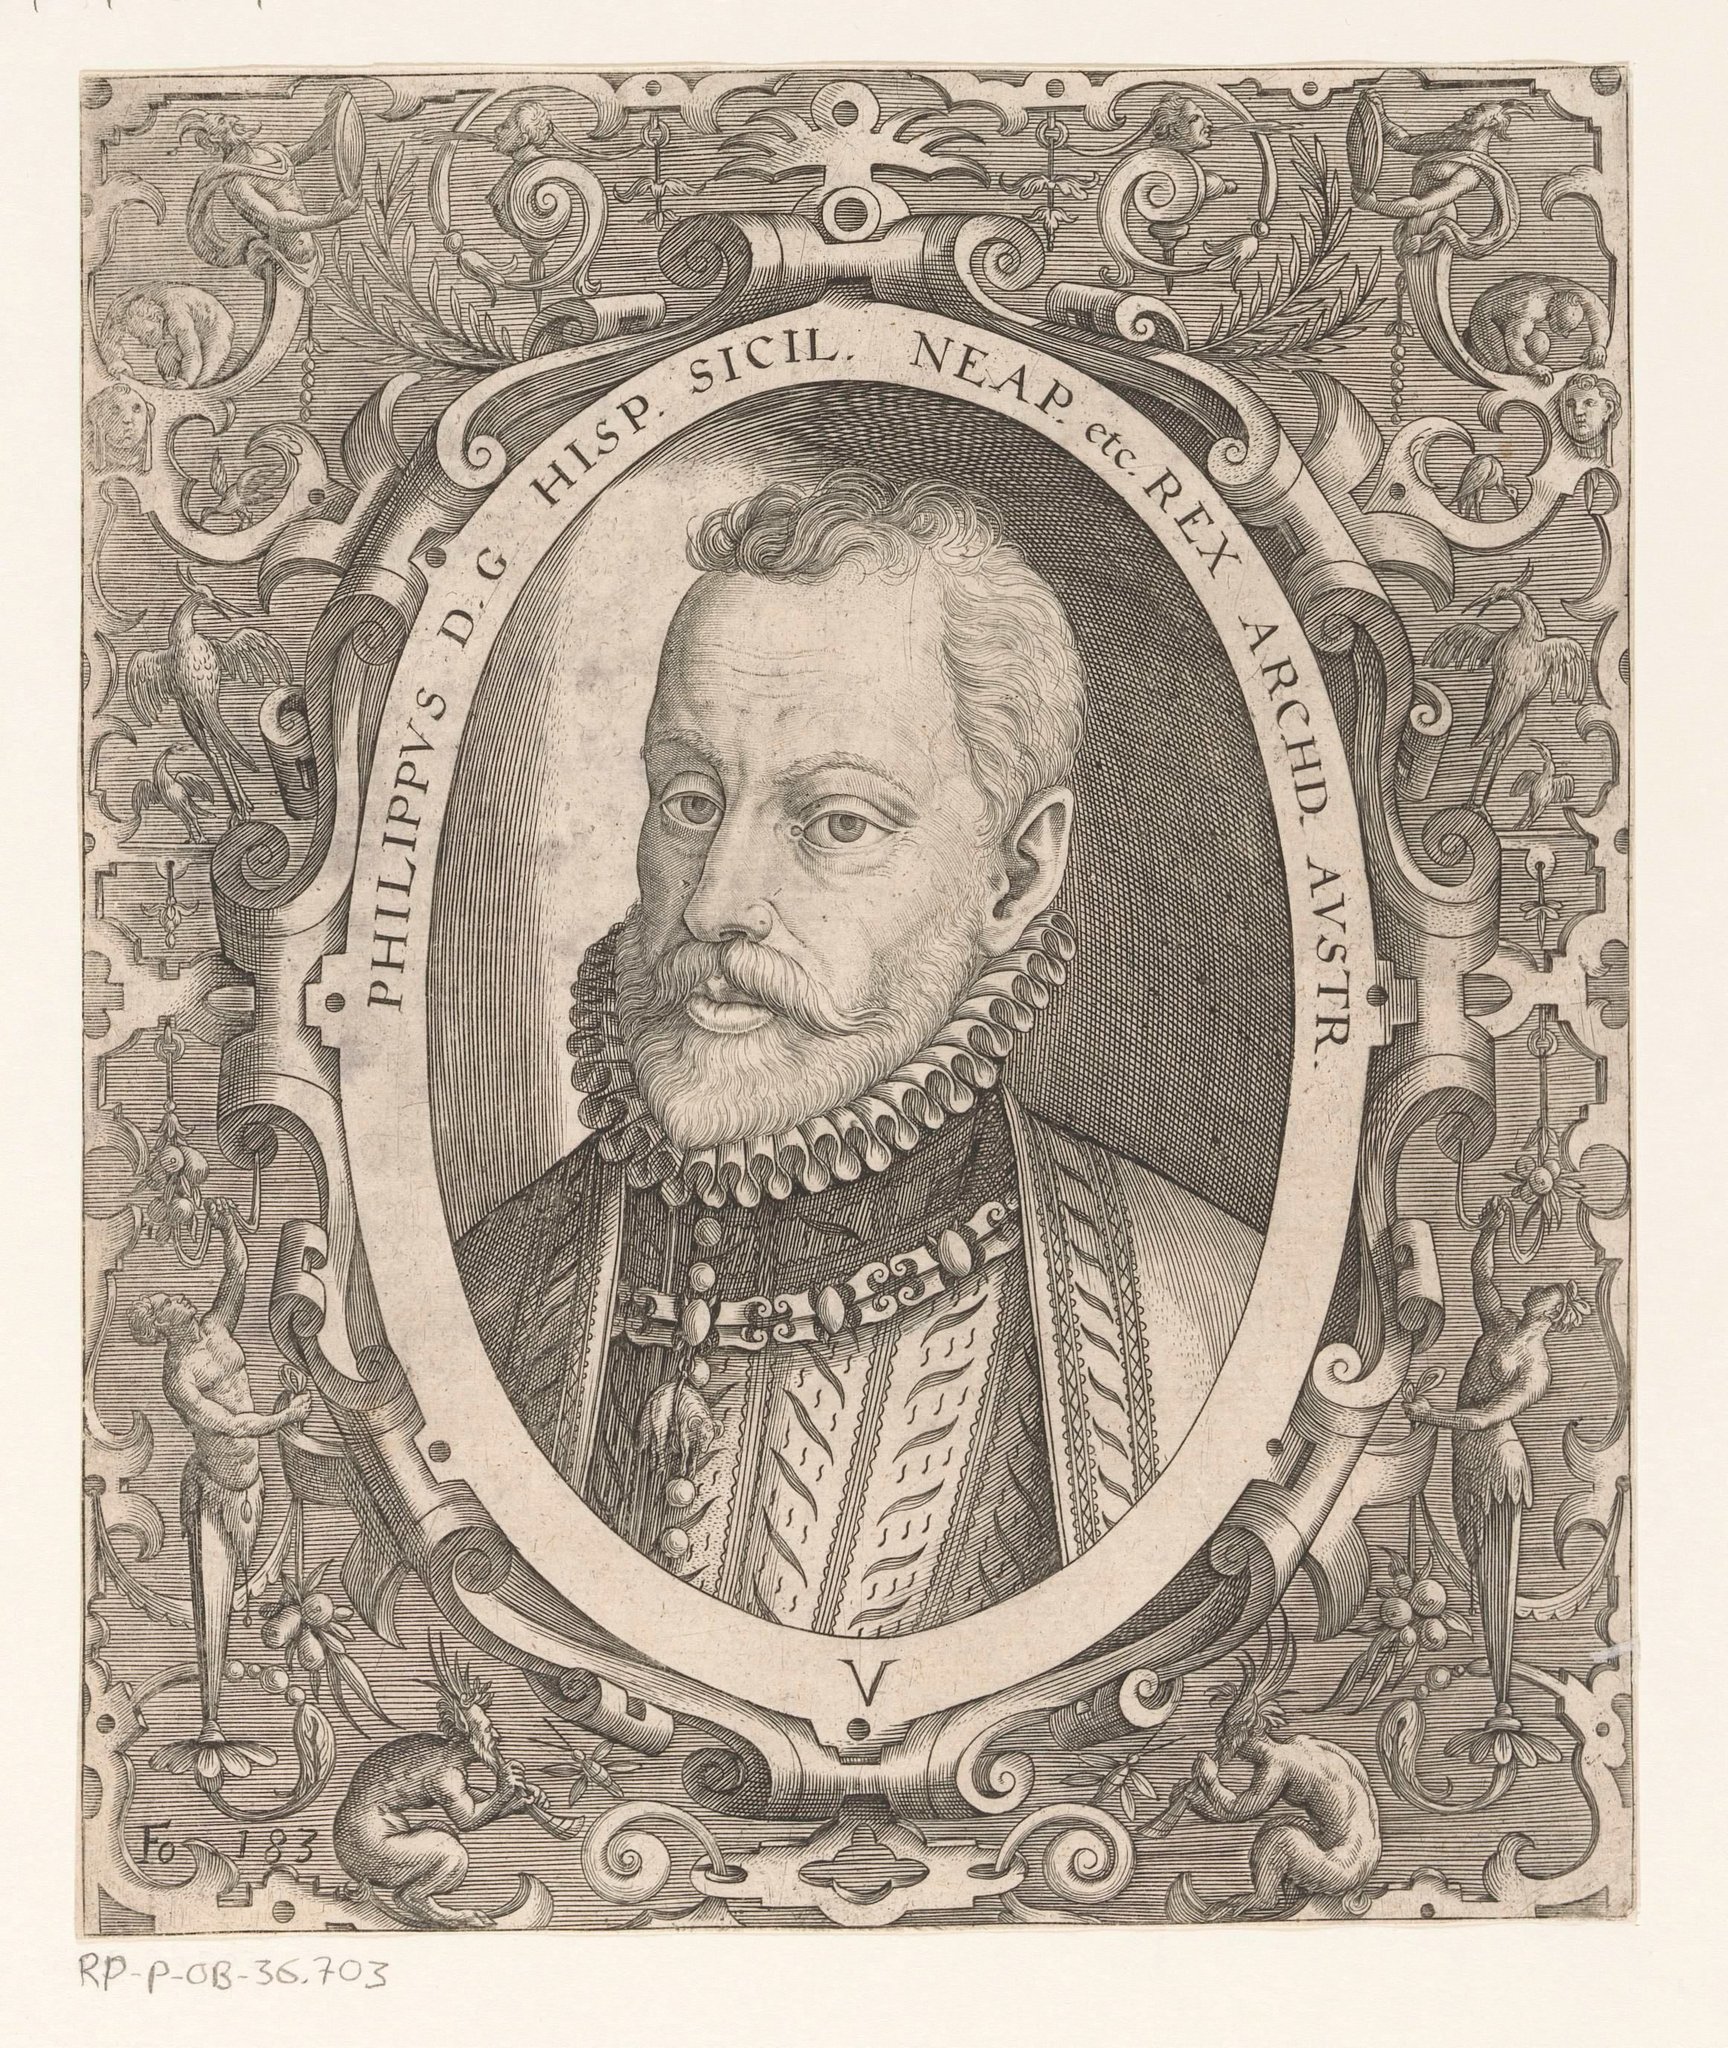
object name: print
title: Portret van Filips II, koning van Spanje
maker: niccolò nelli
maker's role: print maker, publisher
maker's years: 1535-1585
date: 1569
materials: paper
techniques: engraving, etching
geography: venice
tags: philip ii of spain, ornament derived from animal forms, fruits and vegetables ~ ornament, historical persons, ruler, sovereign, knighthood order of the golden fleece - insignia of a knighthood order, e.g.: badge, chain (with name of order)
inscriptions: collector's mark: Lugt 2228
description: Prent uit een serie portretten van onbekende omvang getiteld 'Imagines Quorundam Principum et Illustrium Virorum' met prenten door Niccolò Nelli, Domenico Zenoi, Martino Rota, Nicolas Bèatrizet en Cornelis Cort, uitgegeven in 1569 te Venetië.